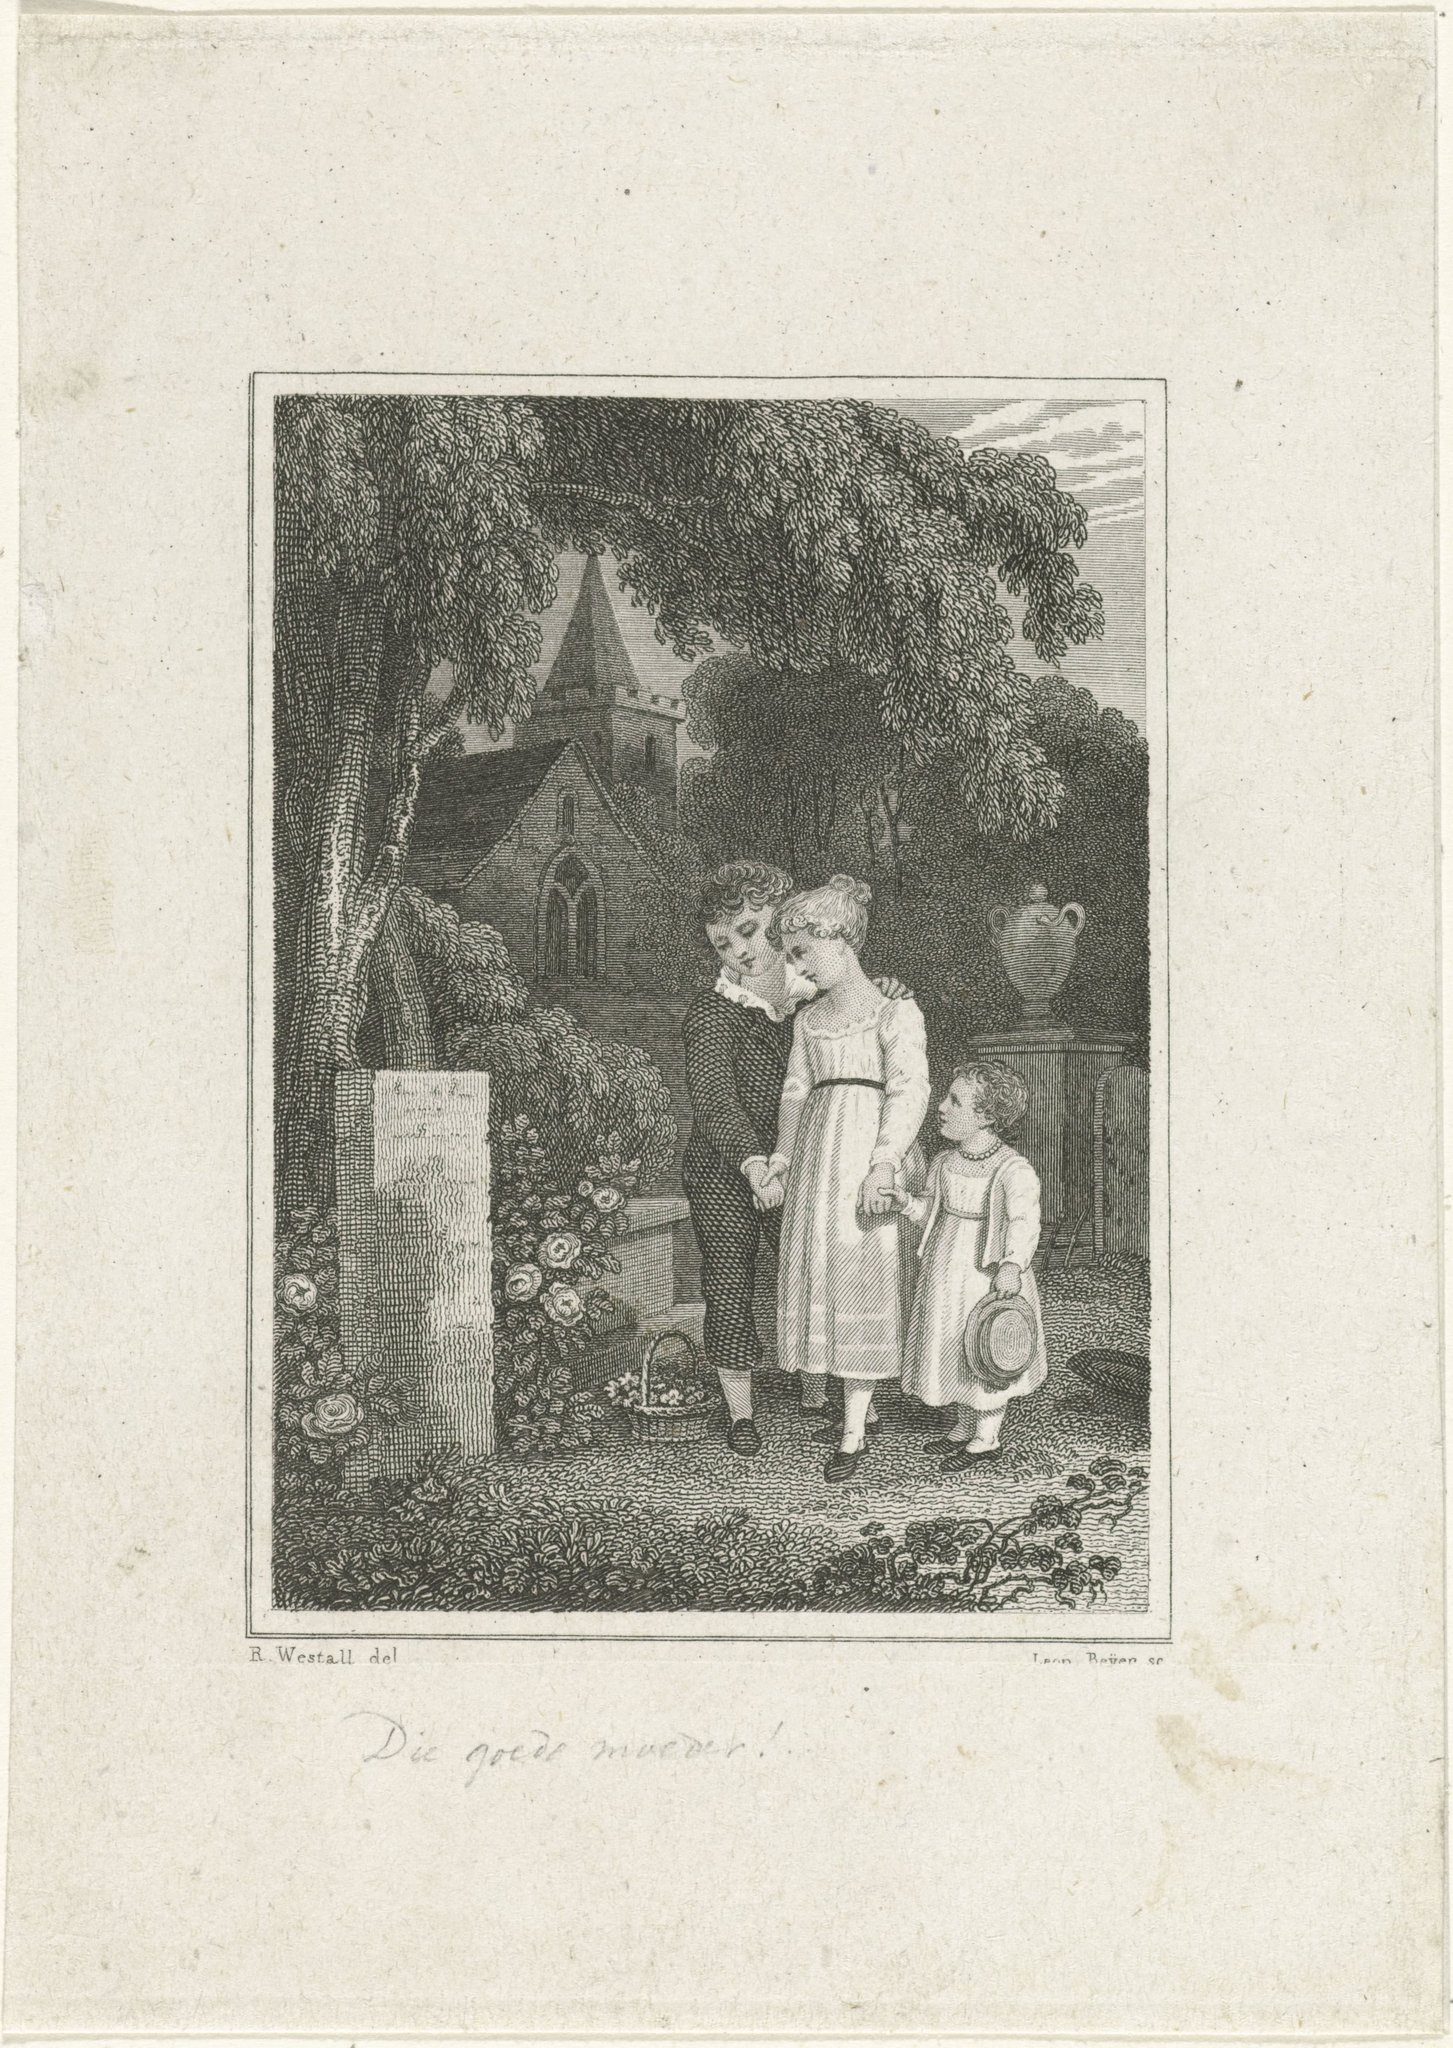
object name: print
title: Drie kinderen bij het graf van hun moeder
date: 1830-1877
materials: paper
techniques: etching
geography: vienna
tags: grave, tomb, brothers or sisters (second degree family relationships)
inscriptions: inscription: ‘Die goede moeder!’, collector's mark: Lugt 2228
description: Drie kinderen bij het graf van hun moeder. Op de achtergrond een kerk.